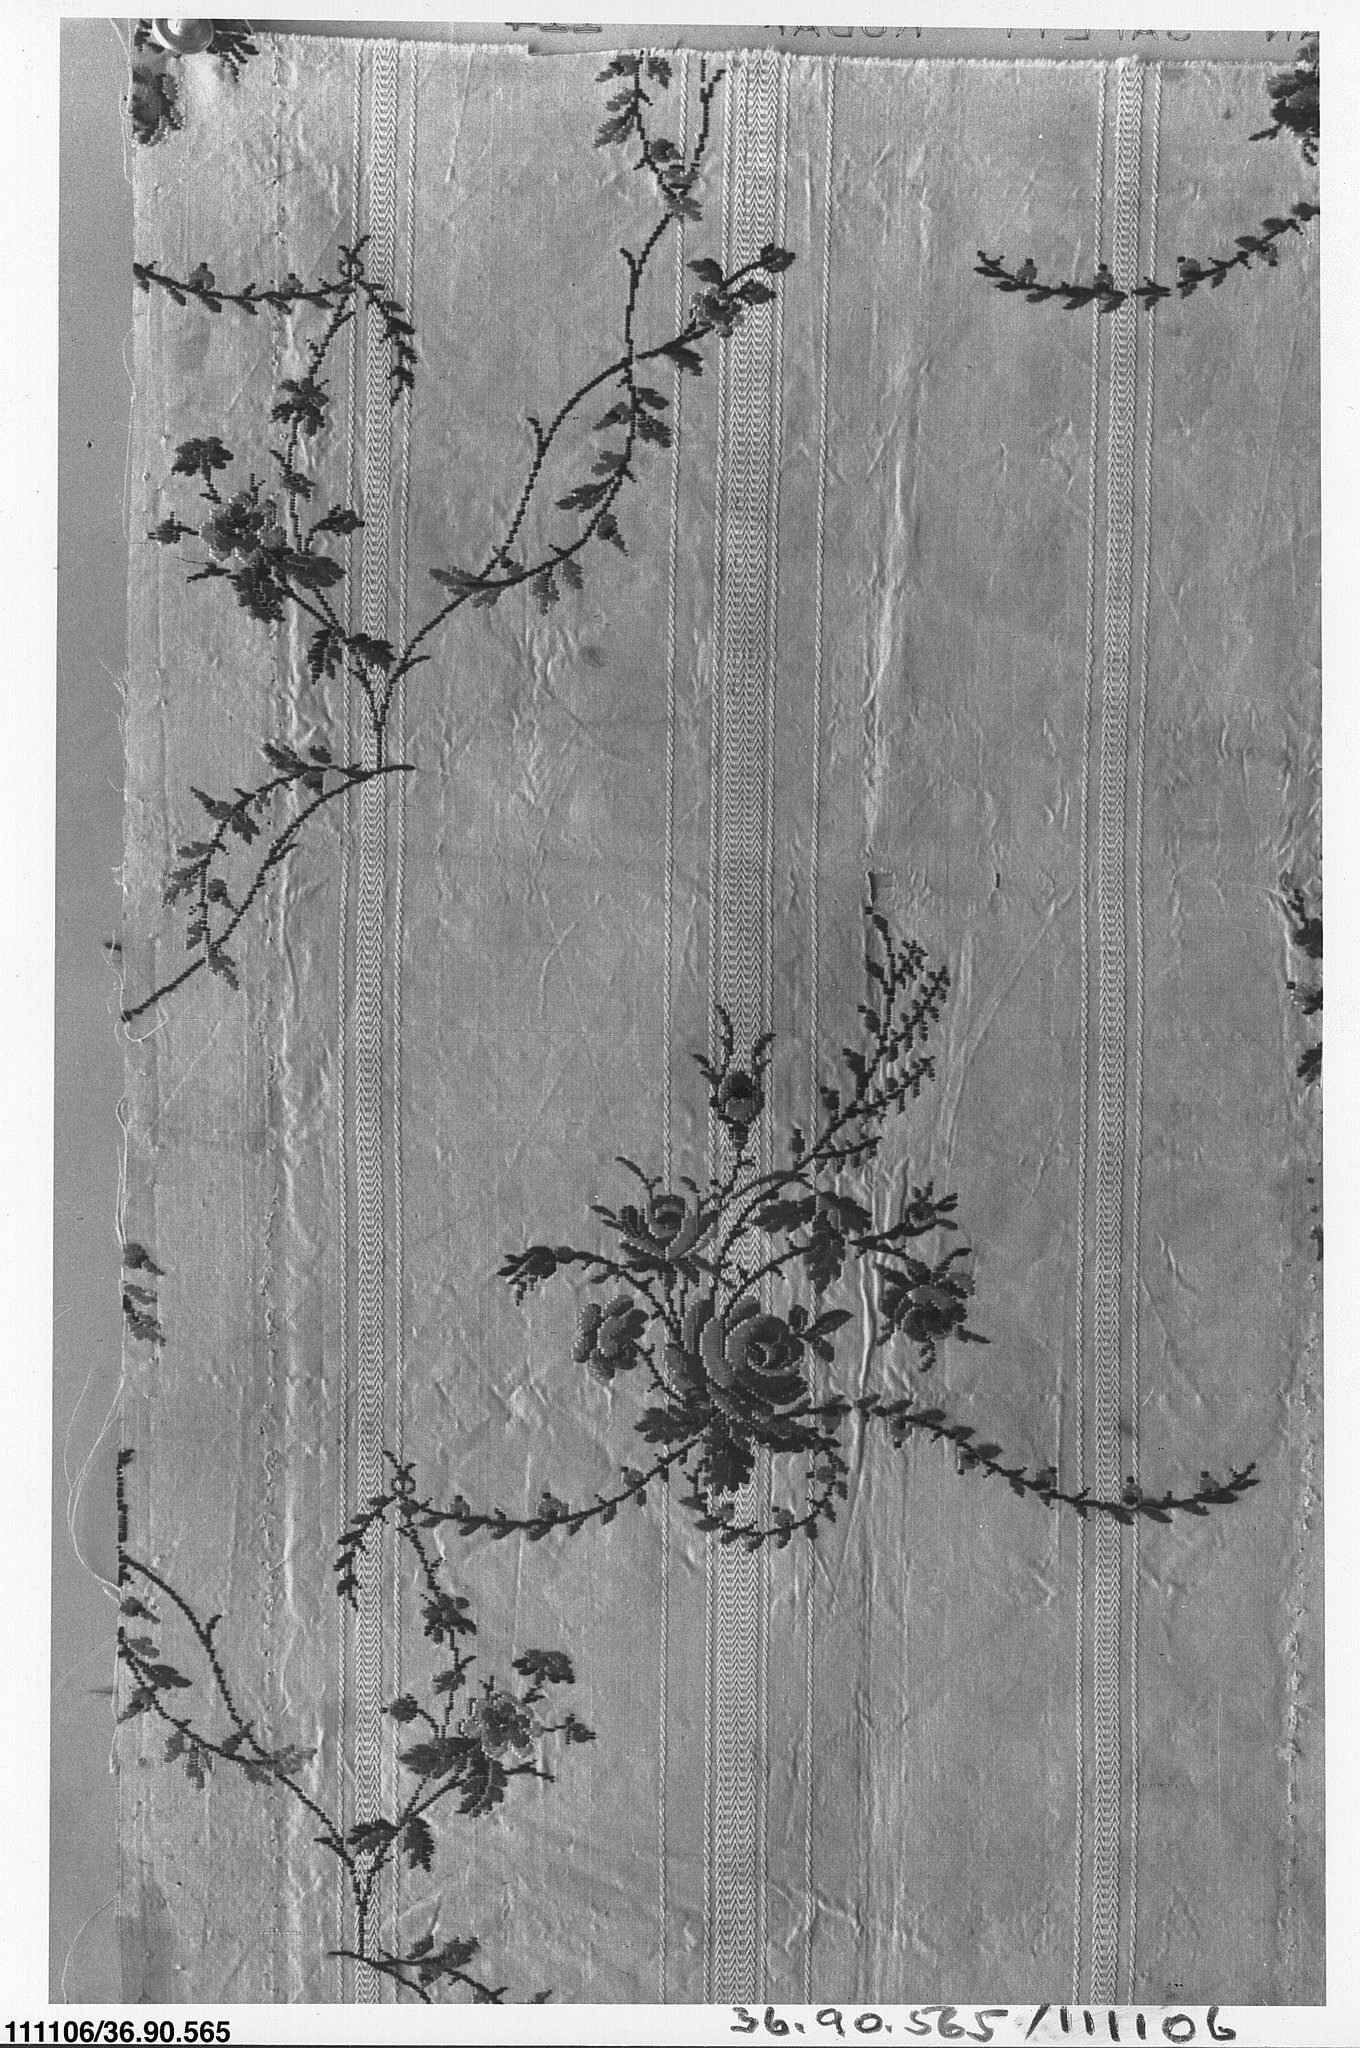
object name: piece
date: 1767-1800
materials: silk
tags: flowers